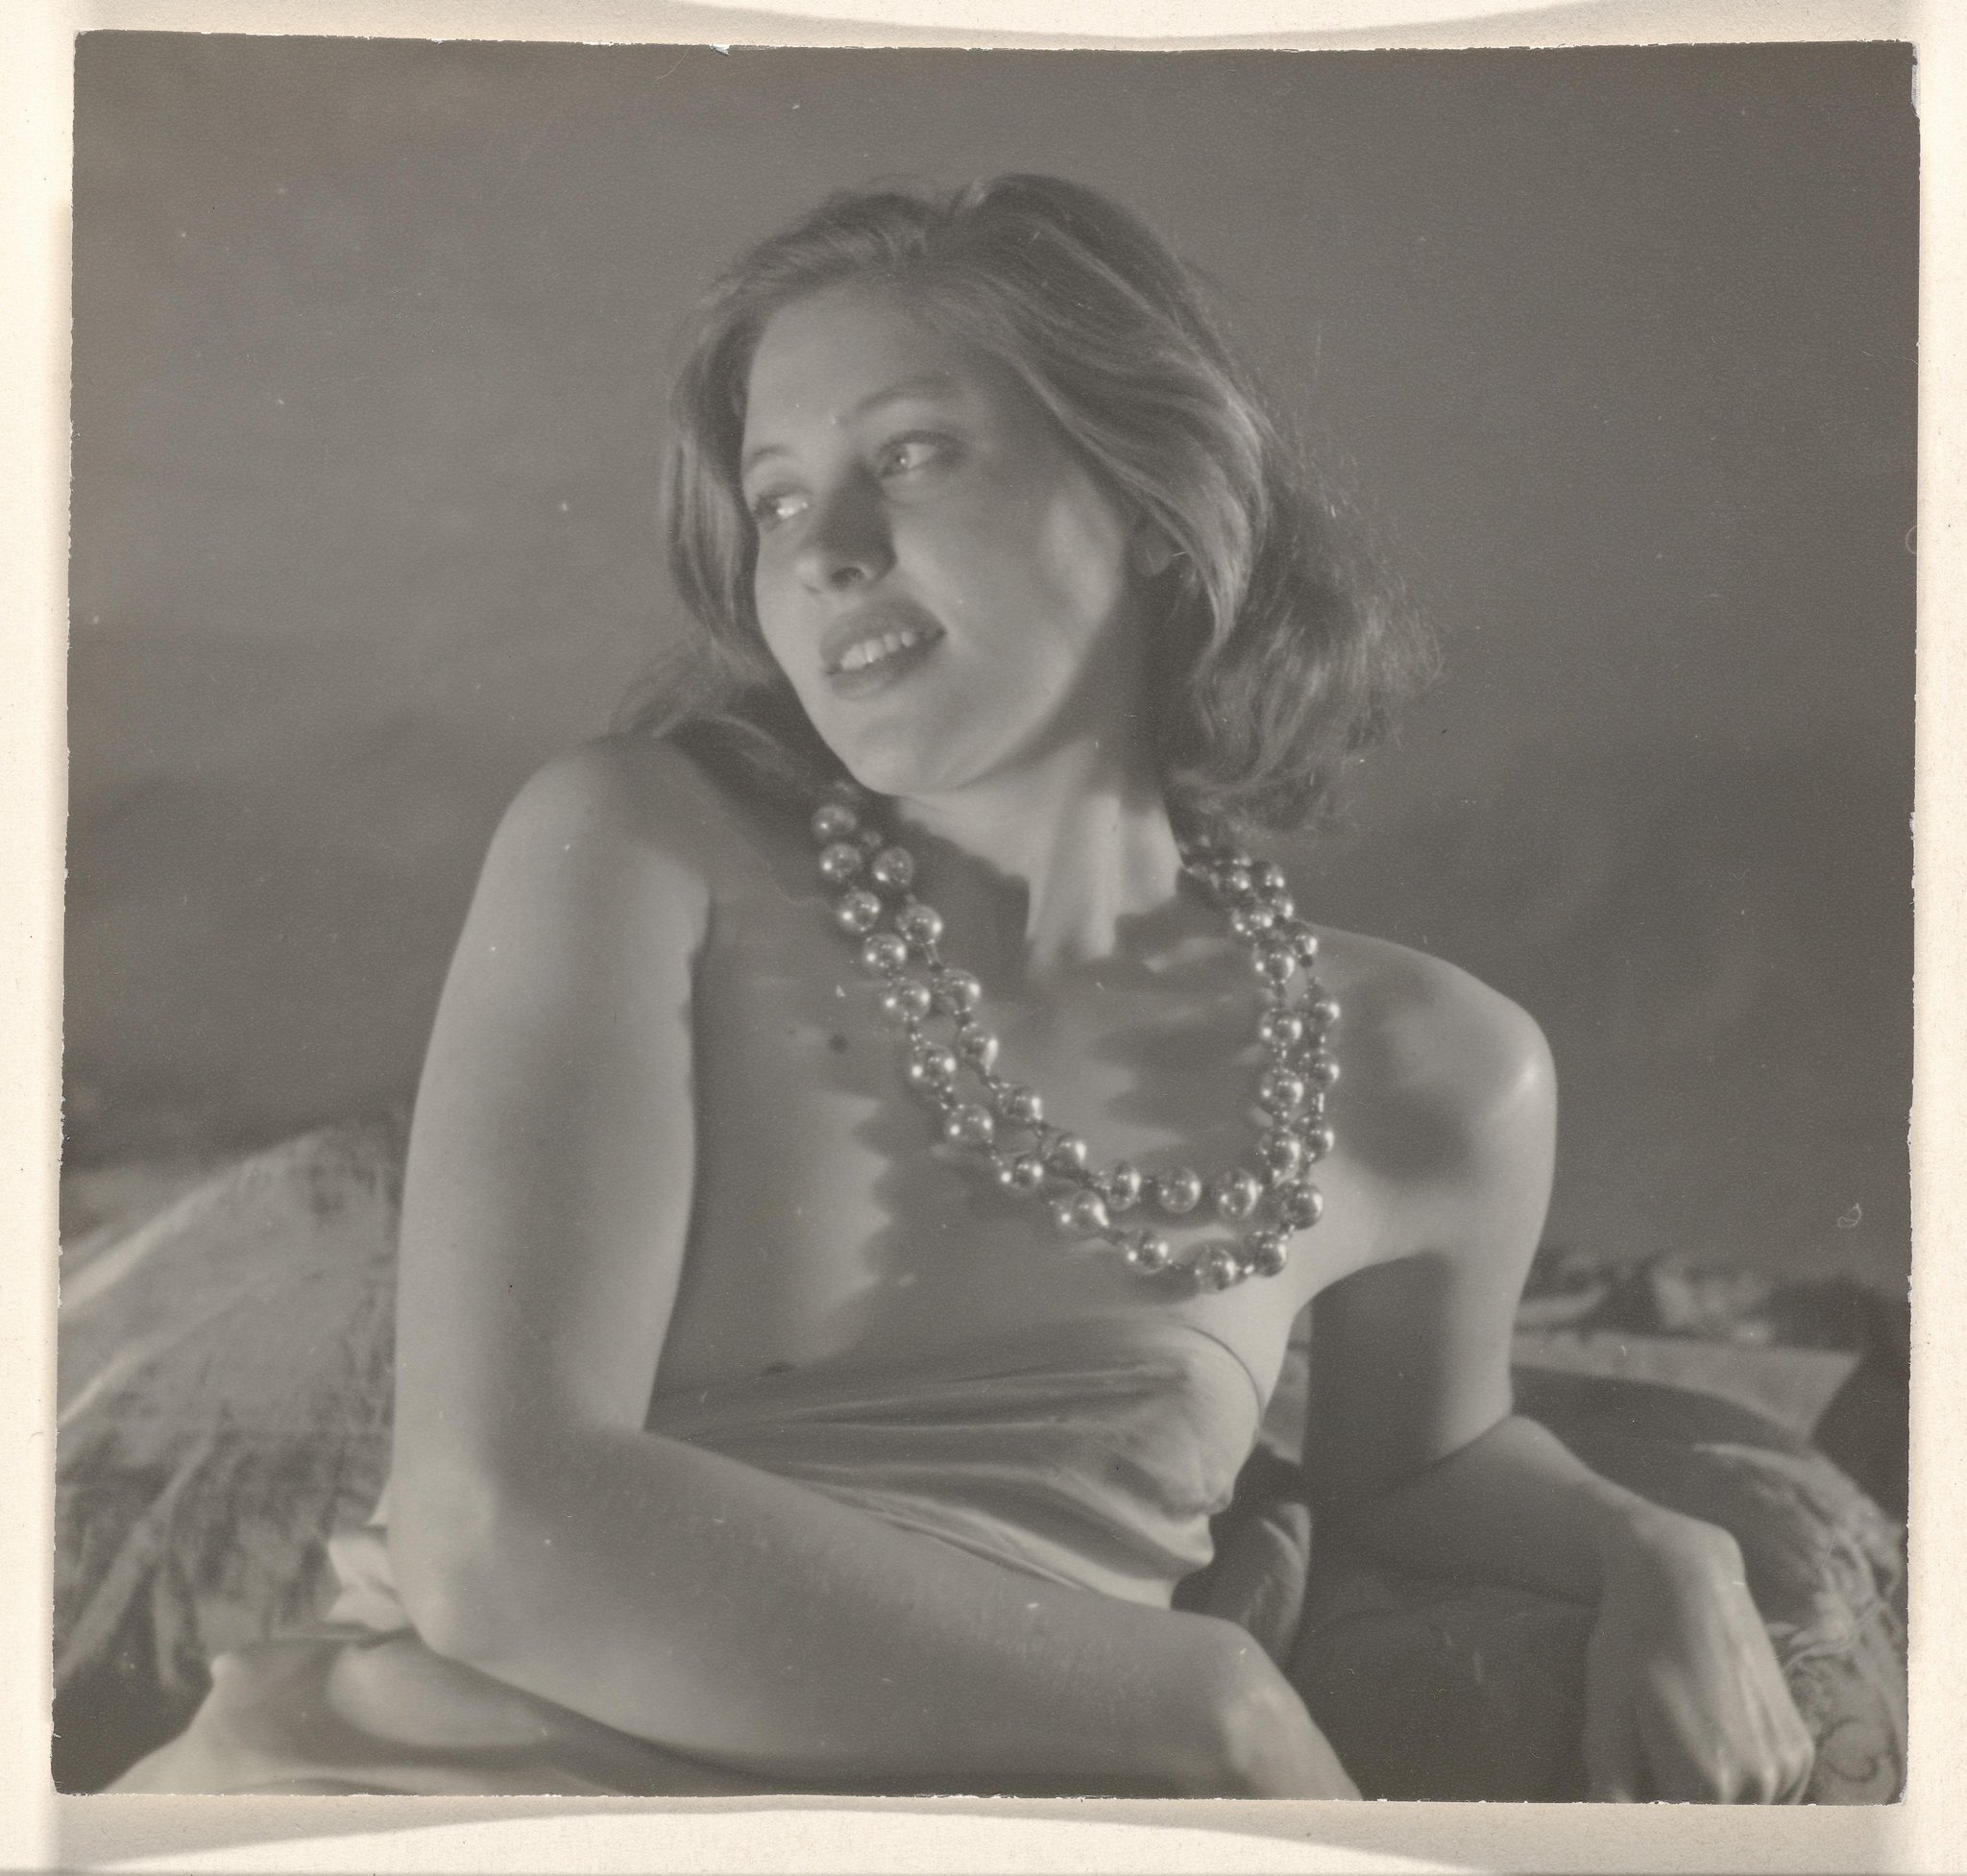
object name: photograph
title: Portret van een blond model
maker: Anonymous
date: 1945-1955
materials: photographic support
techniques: gelatin silver print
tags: historical persons not known by name - bb - woman, chest, bust - aa - female human figure